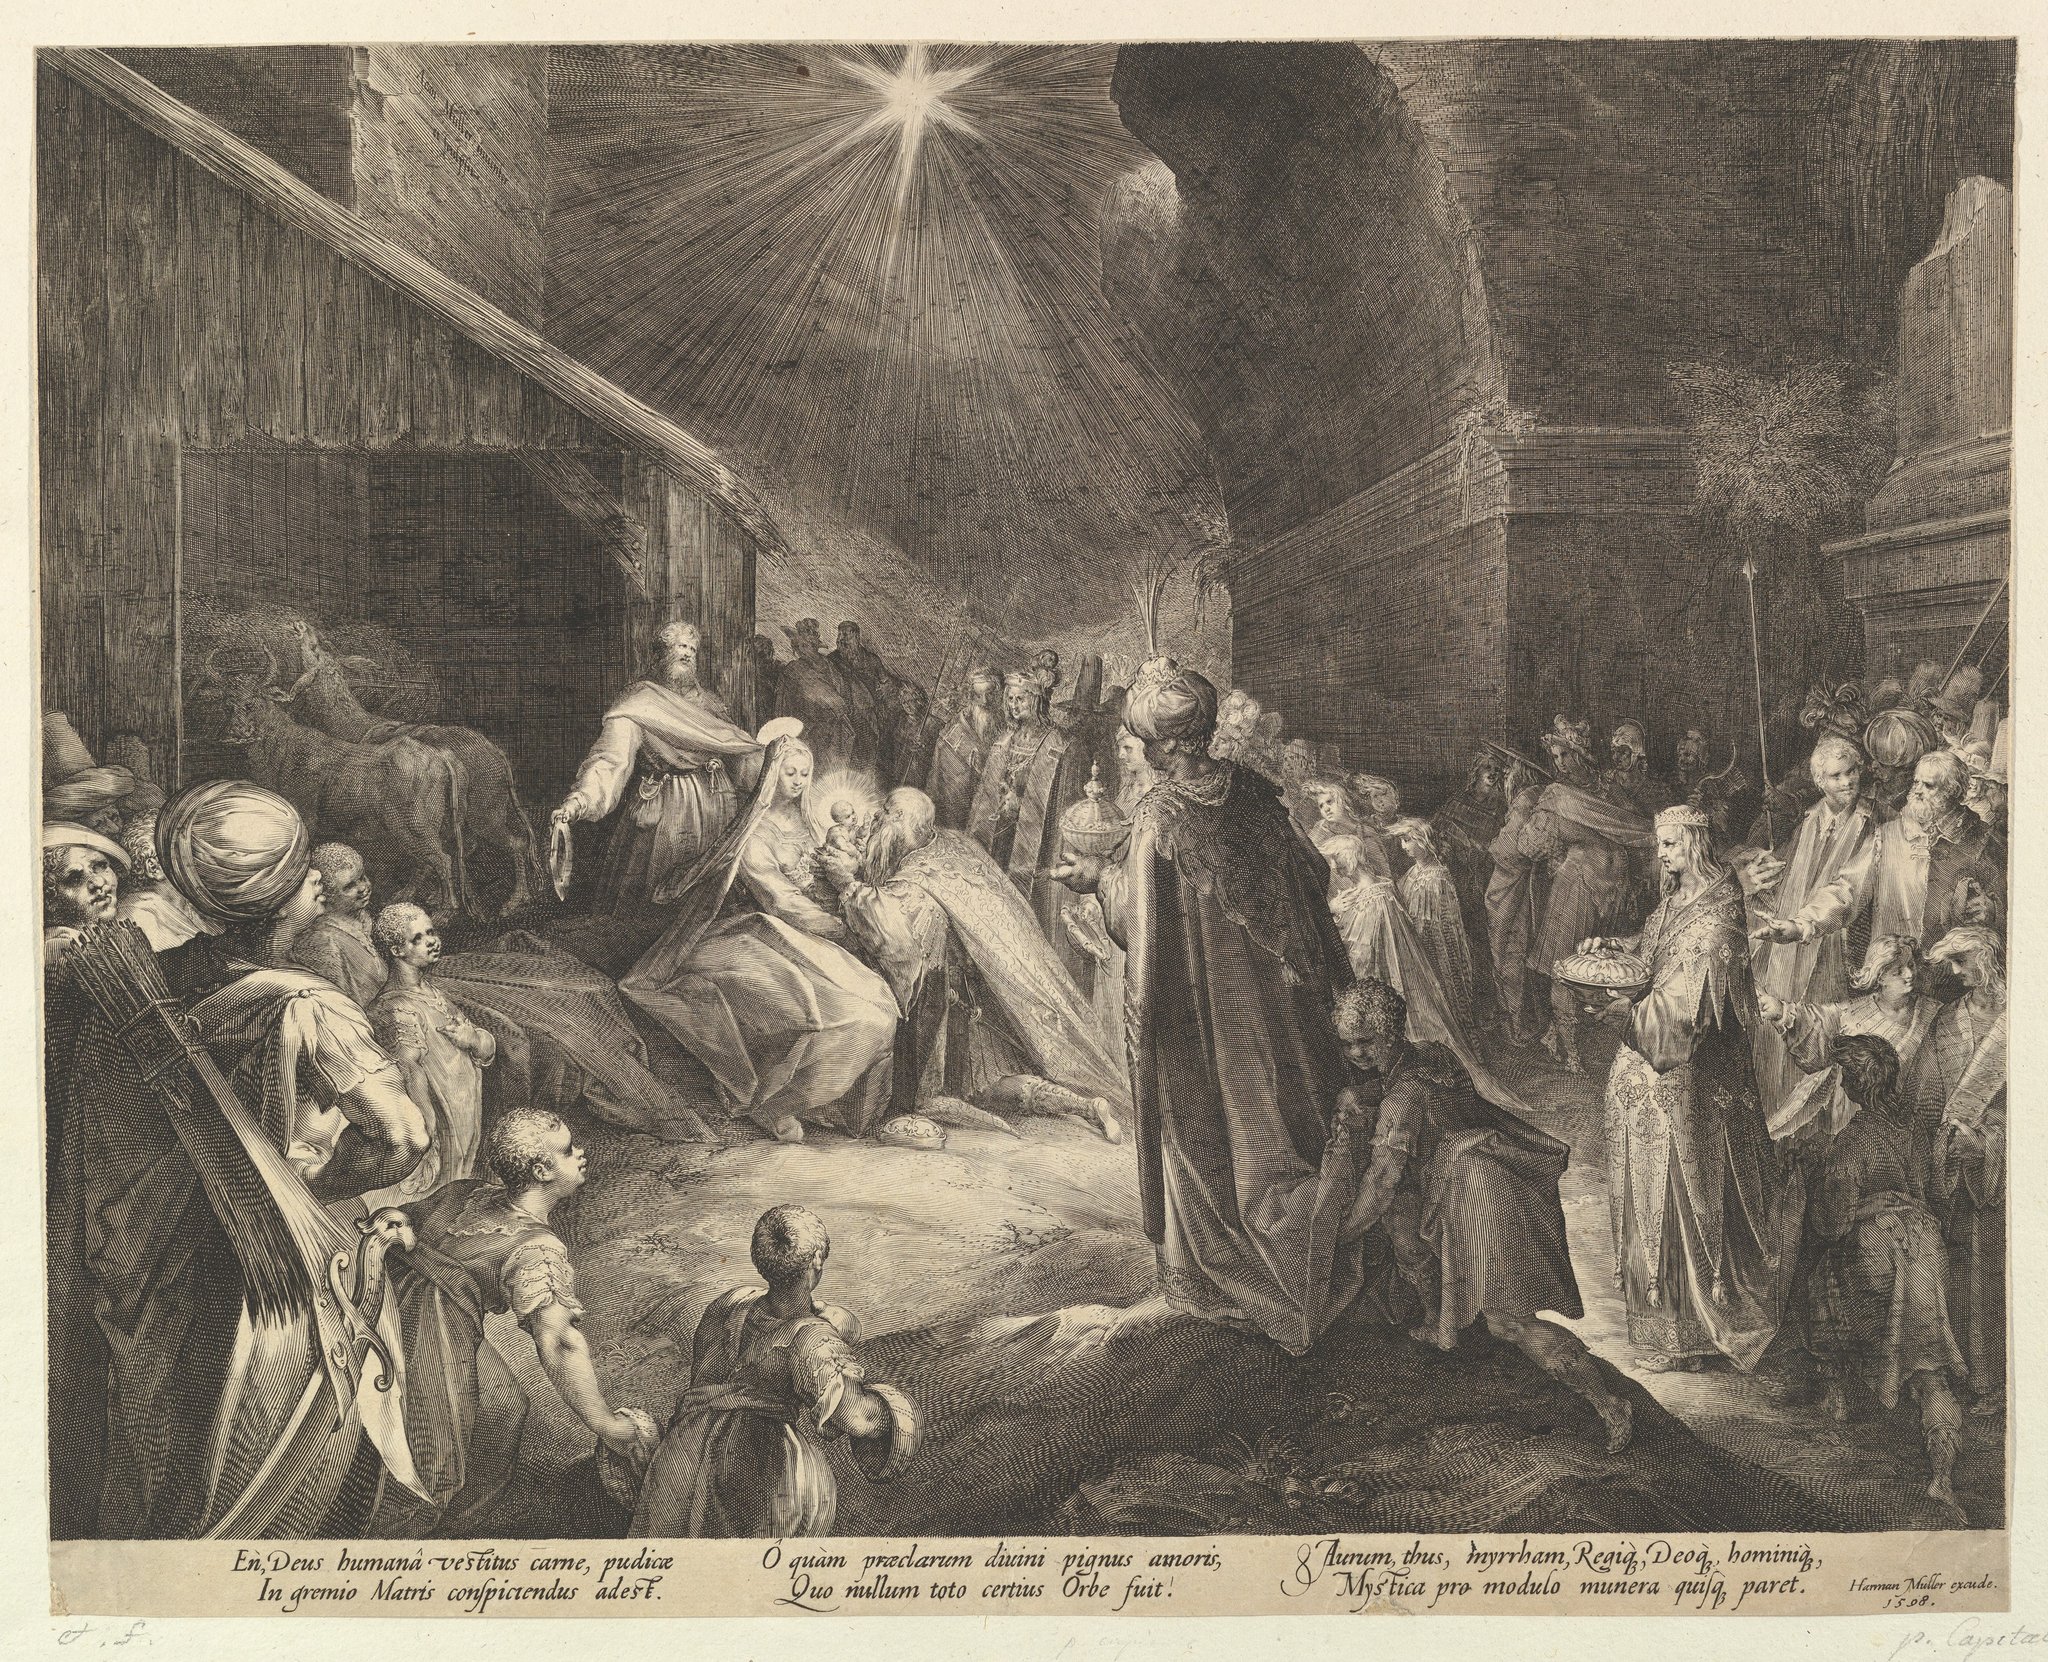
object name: print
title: The Adoration of the Magi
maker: jan muller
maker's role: artist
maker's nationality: netherlandish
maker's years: 1571-1628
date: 1598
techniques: engraving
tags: adoration of the magi